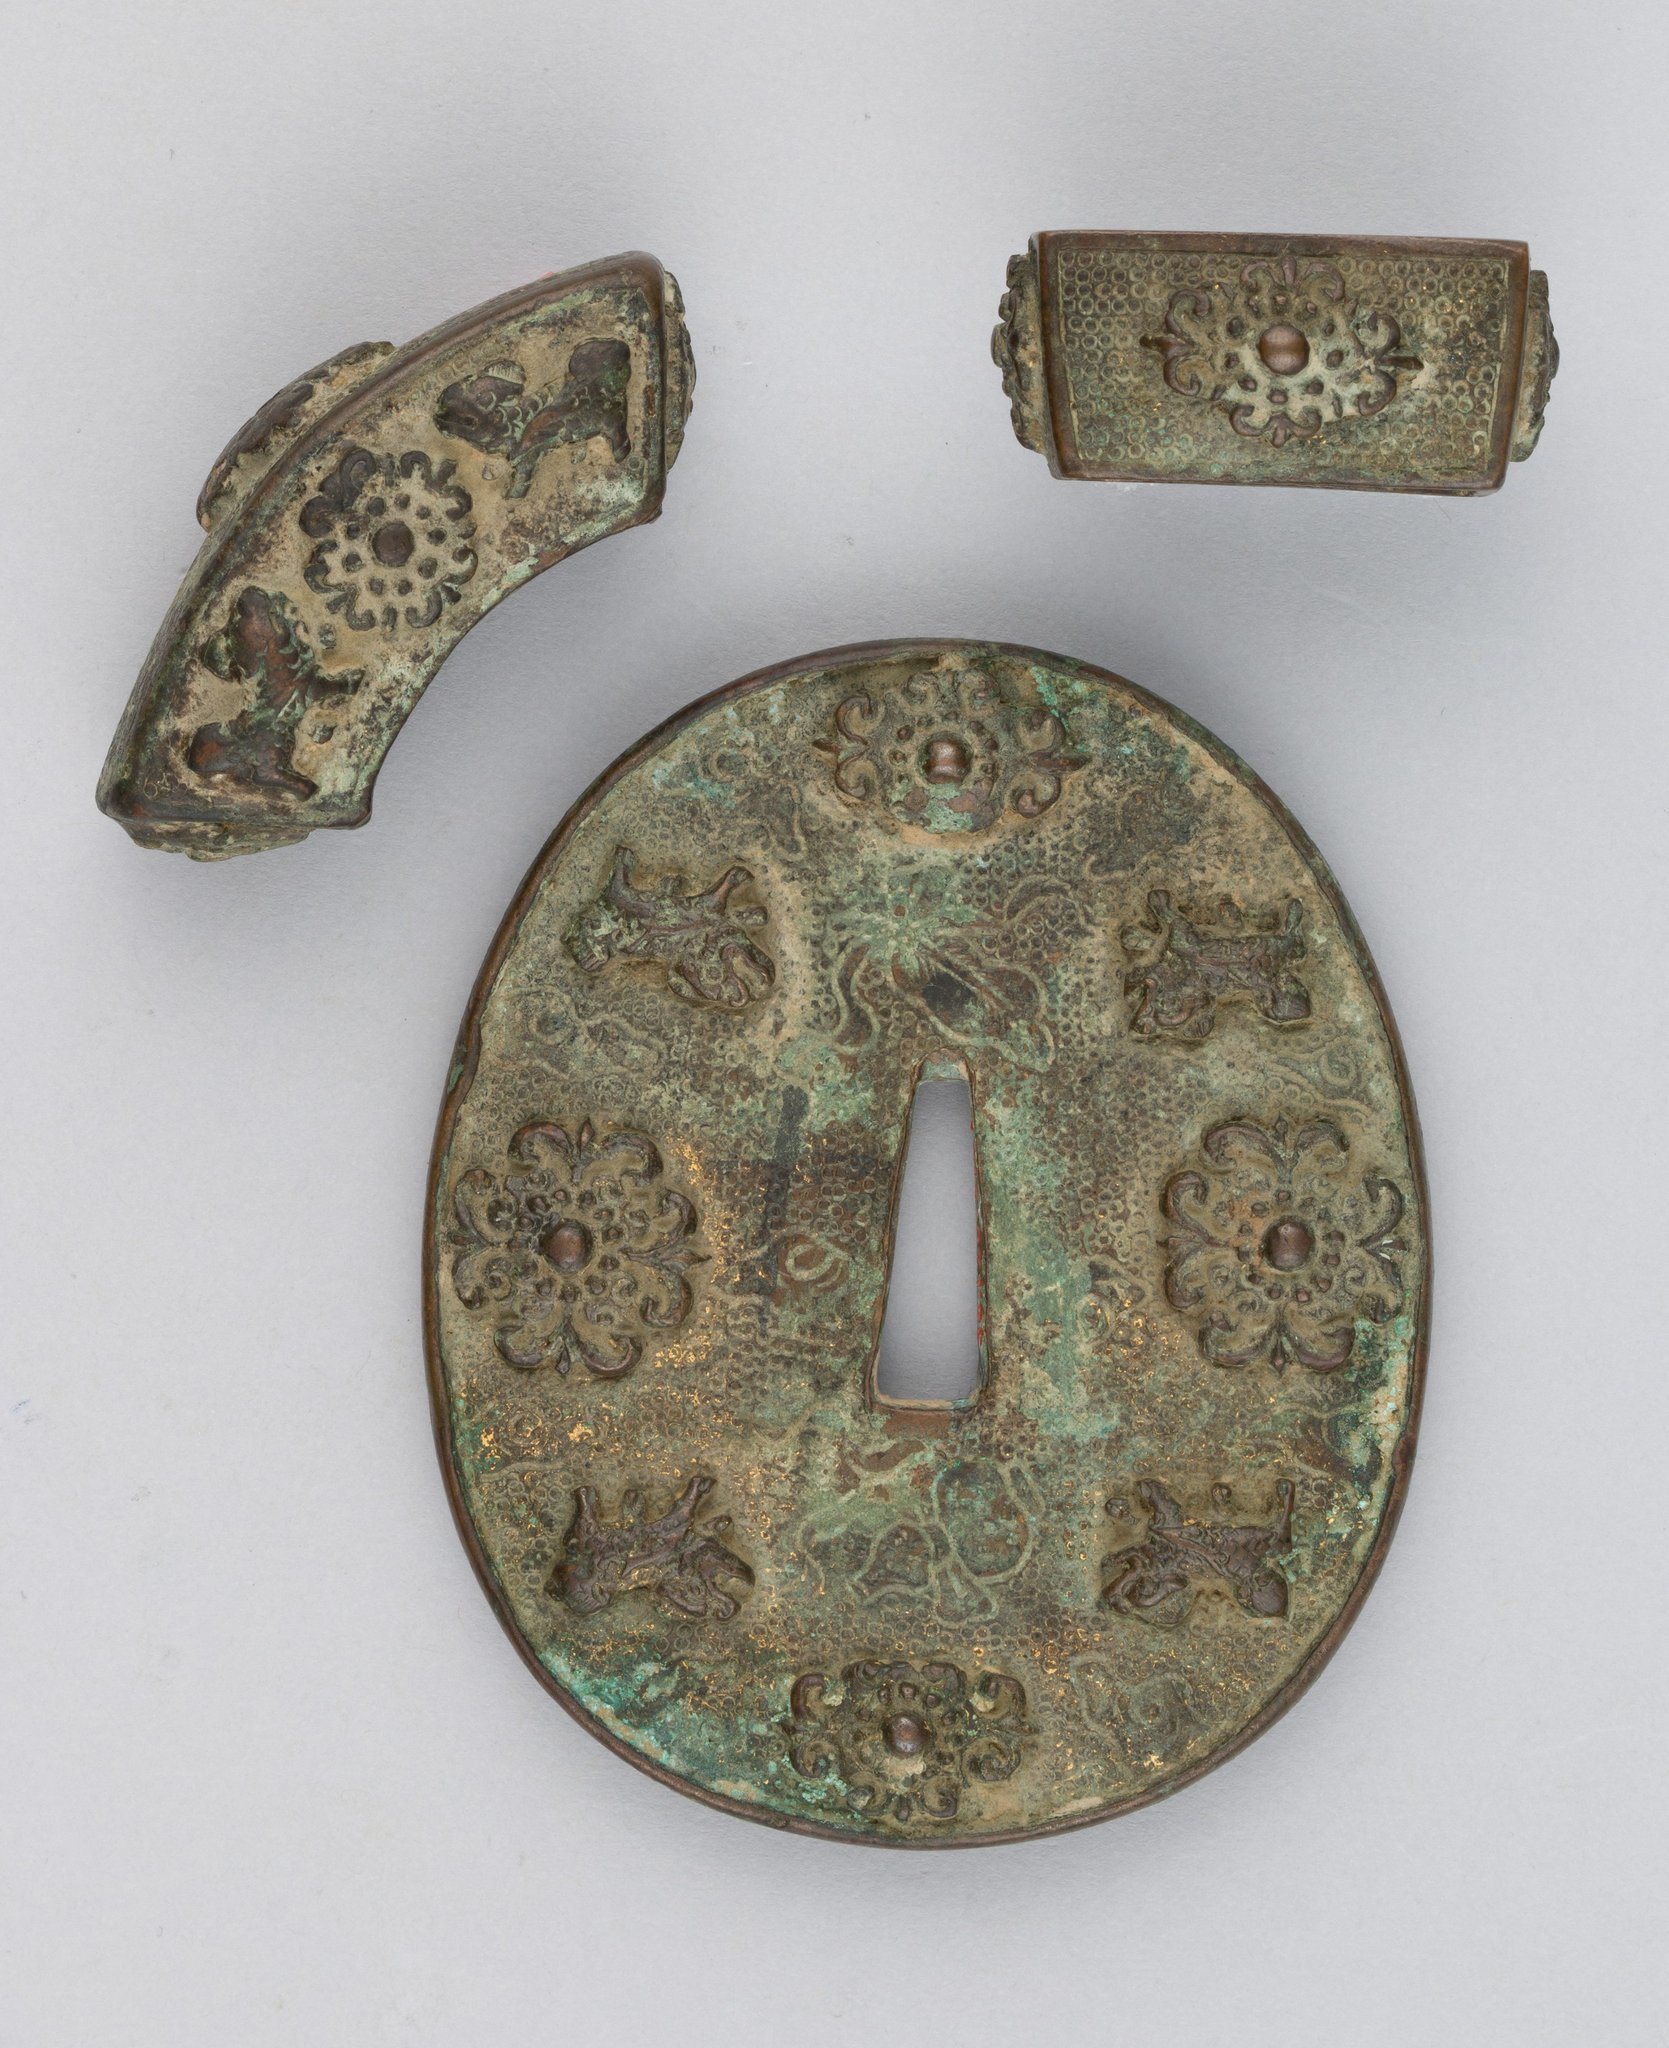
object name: sword guard tsuba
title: Sword Guard (Tsuba)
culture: chinese or japanese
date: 1201-1300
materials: bronze, copper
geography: japan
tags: animals,flowers